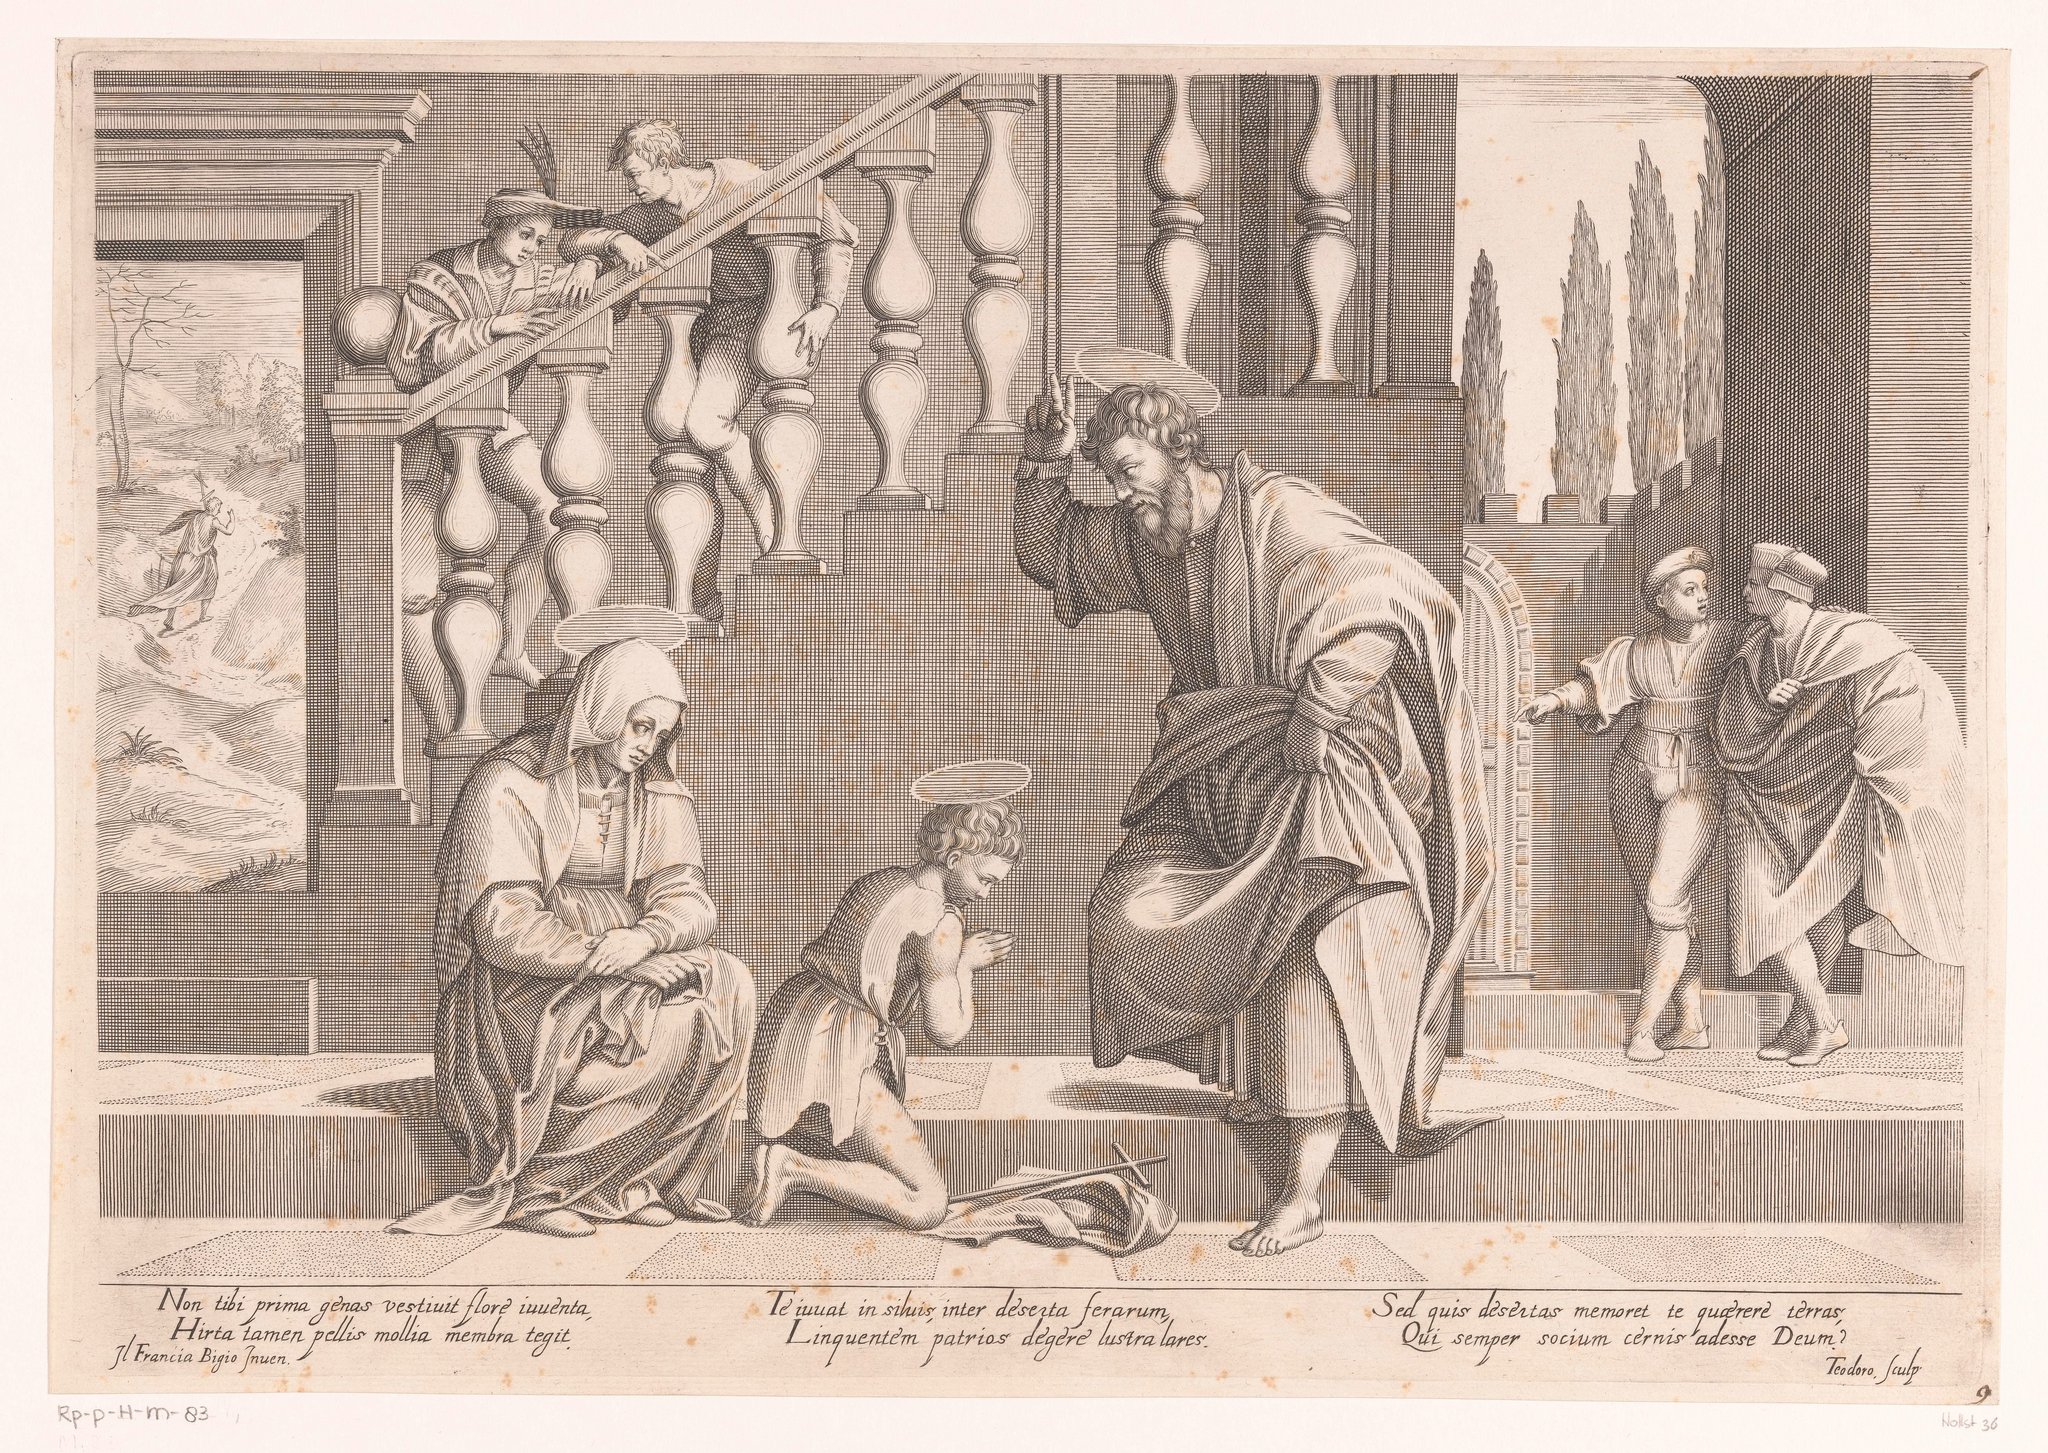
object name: print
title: Johannes de Doper verlaat zijn ouders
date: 1617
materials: paper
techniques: engraving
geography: florence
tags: john the baptist leaves his parents to go into the wilderness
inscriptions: collector's mark: Lugt 11, collector's mark: ‘Hinloopen’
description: Onderdeel van een serie van dertien prenten en een titelprent. Origineel onderdeel geweest van het album Schijnvoet-nummer 24.